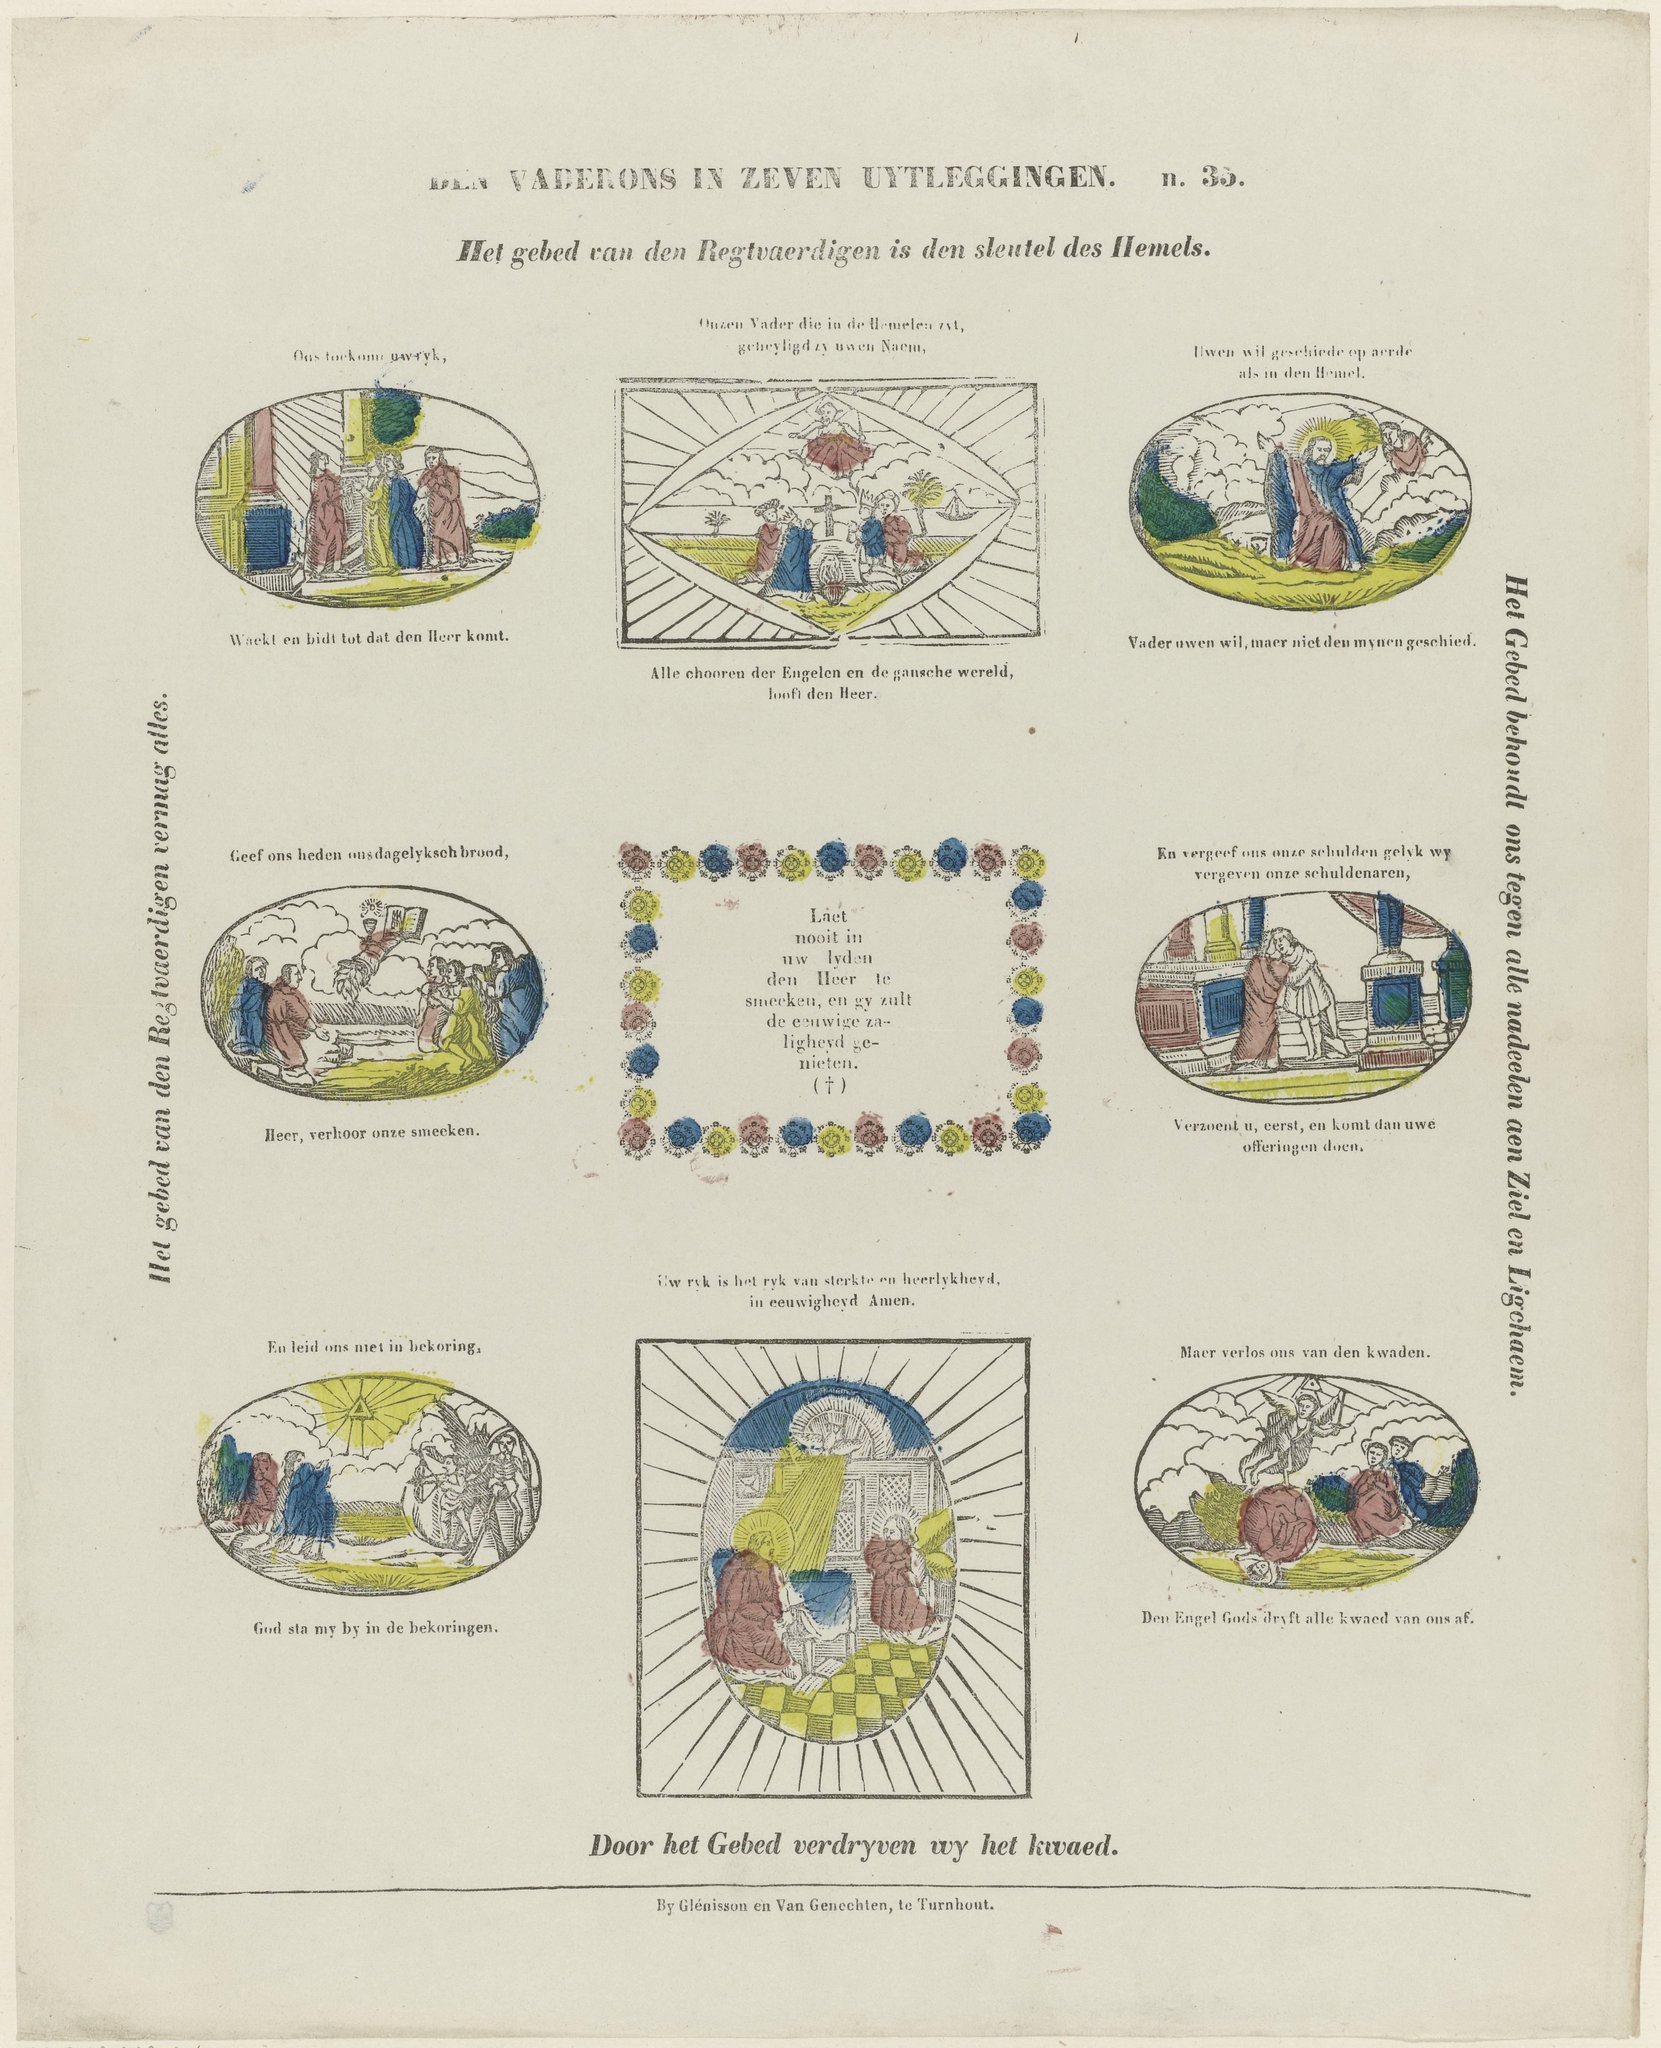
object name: print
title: Den Vaderons in zeven uitleggingen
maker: Anonymous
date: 1833-1856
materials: paper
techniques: colour, letterpress printing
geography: turnhout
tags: the worship of god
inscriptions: collector's mark: Lugt 2760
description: Blad met 8 voorstellingen van biddende mensen. Bij elke afbeelding een onder- en bovenschrift. Genummerd rechtsboven: n. 35.